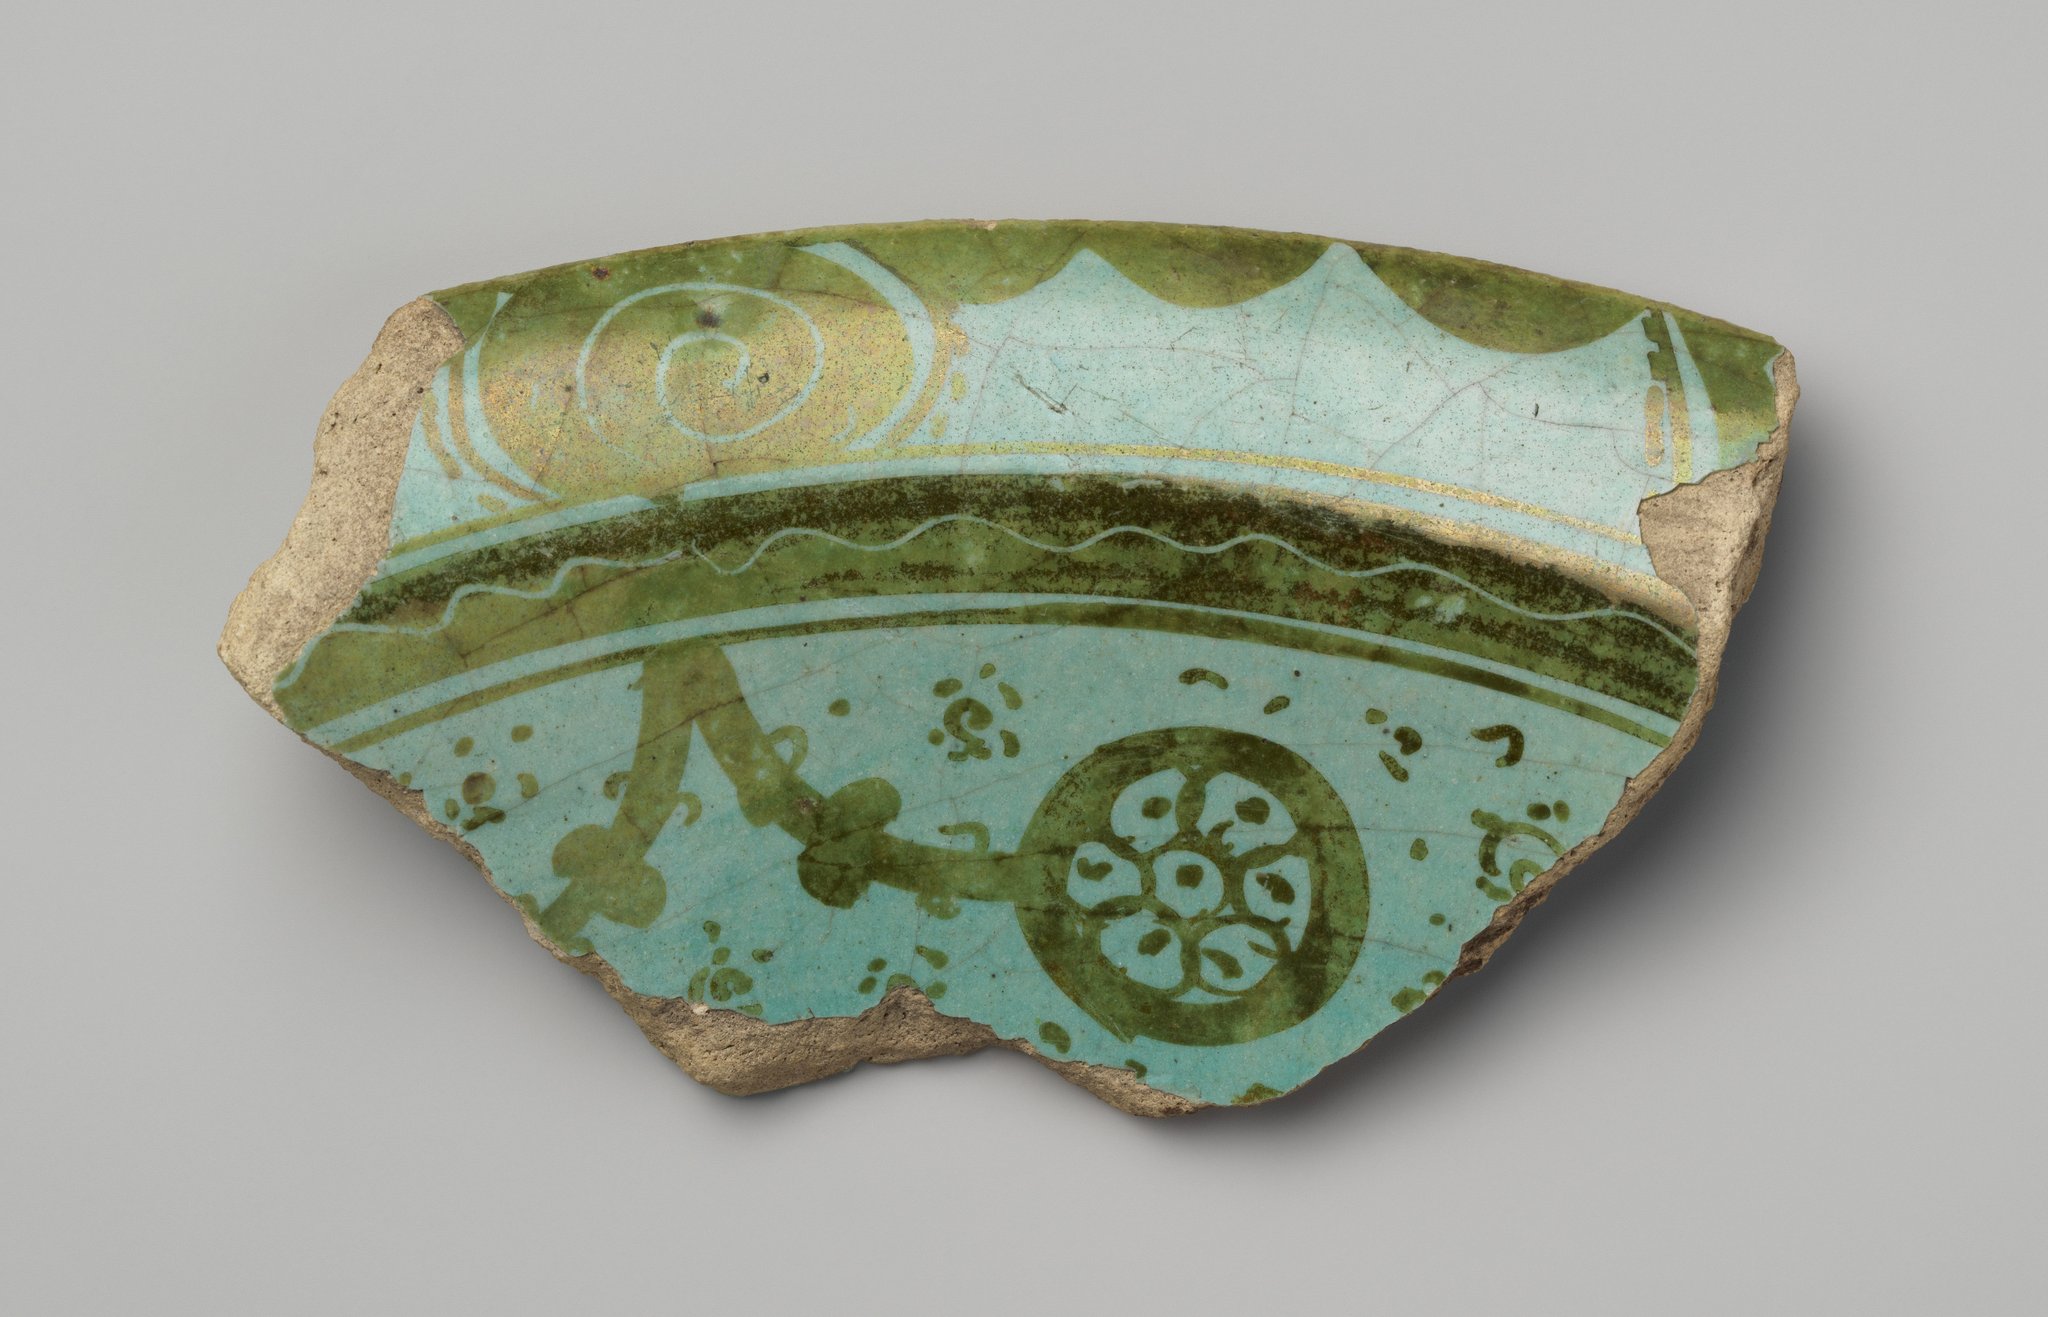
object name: ceramic fragment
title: Fragment of a Luster Dish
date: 1001-1200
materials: stonepaste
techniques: glazing, luster painting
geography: syria